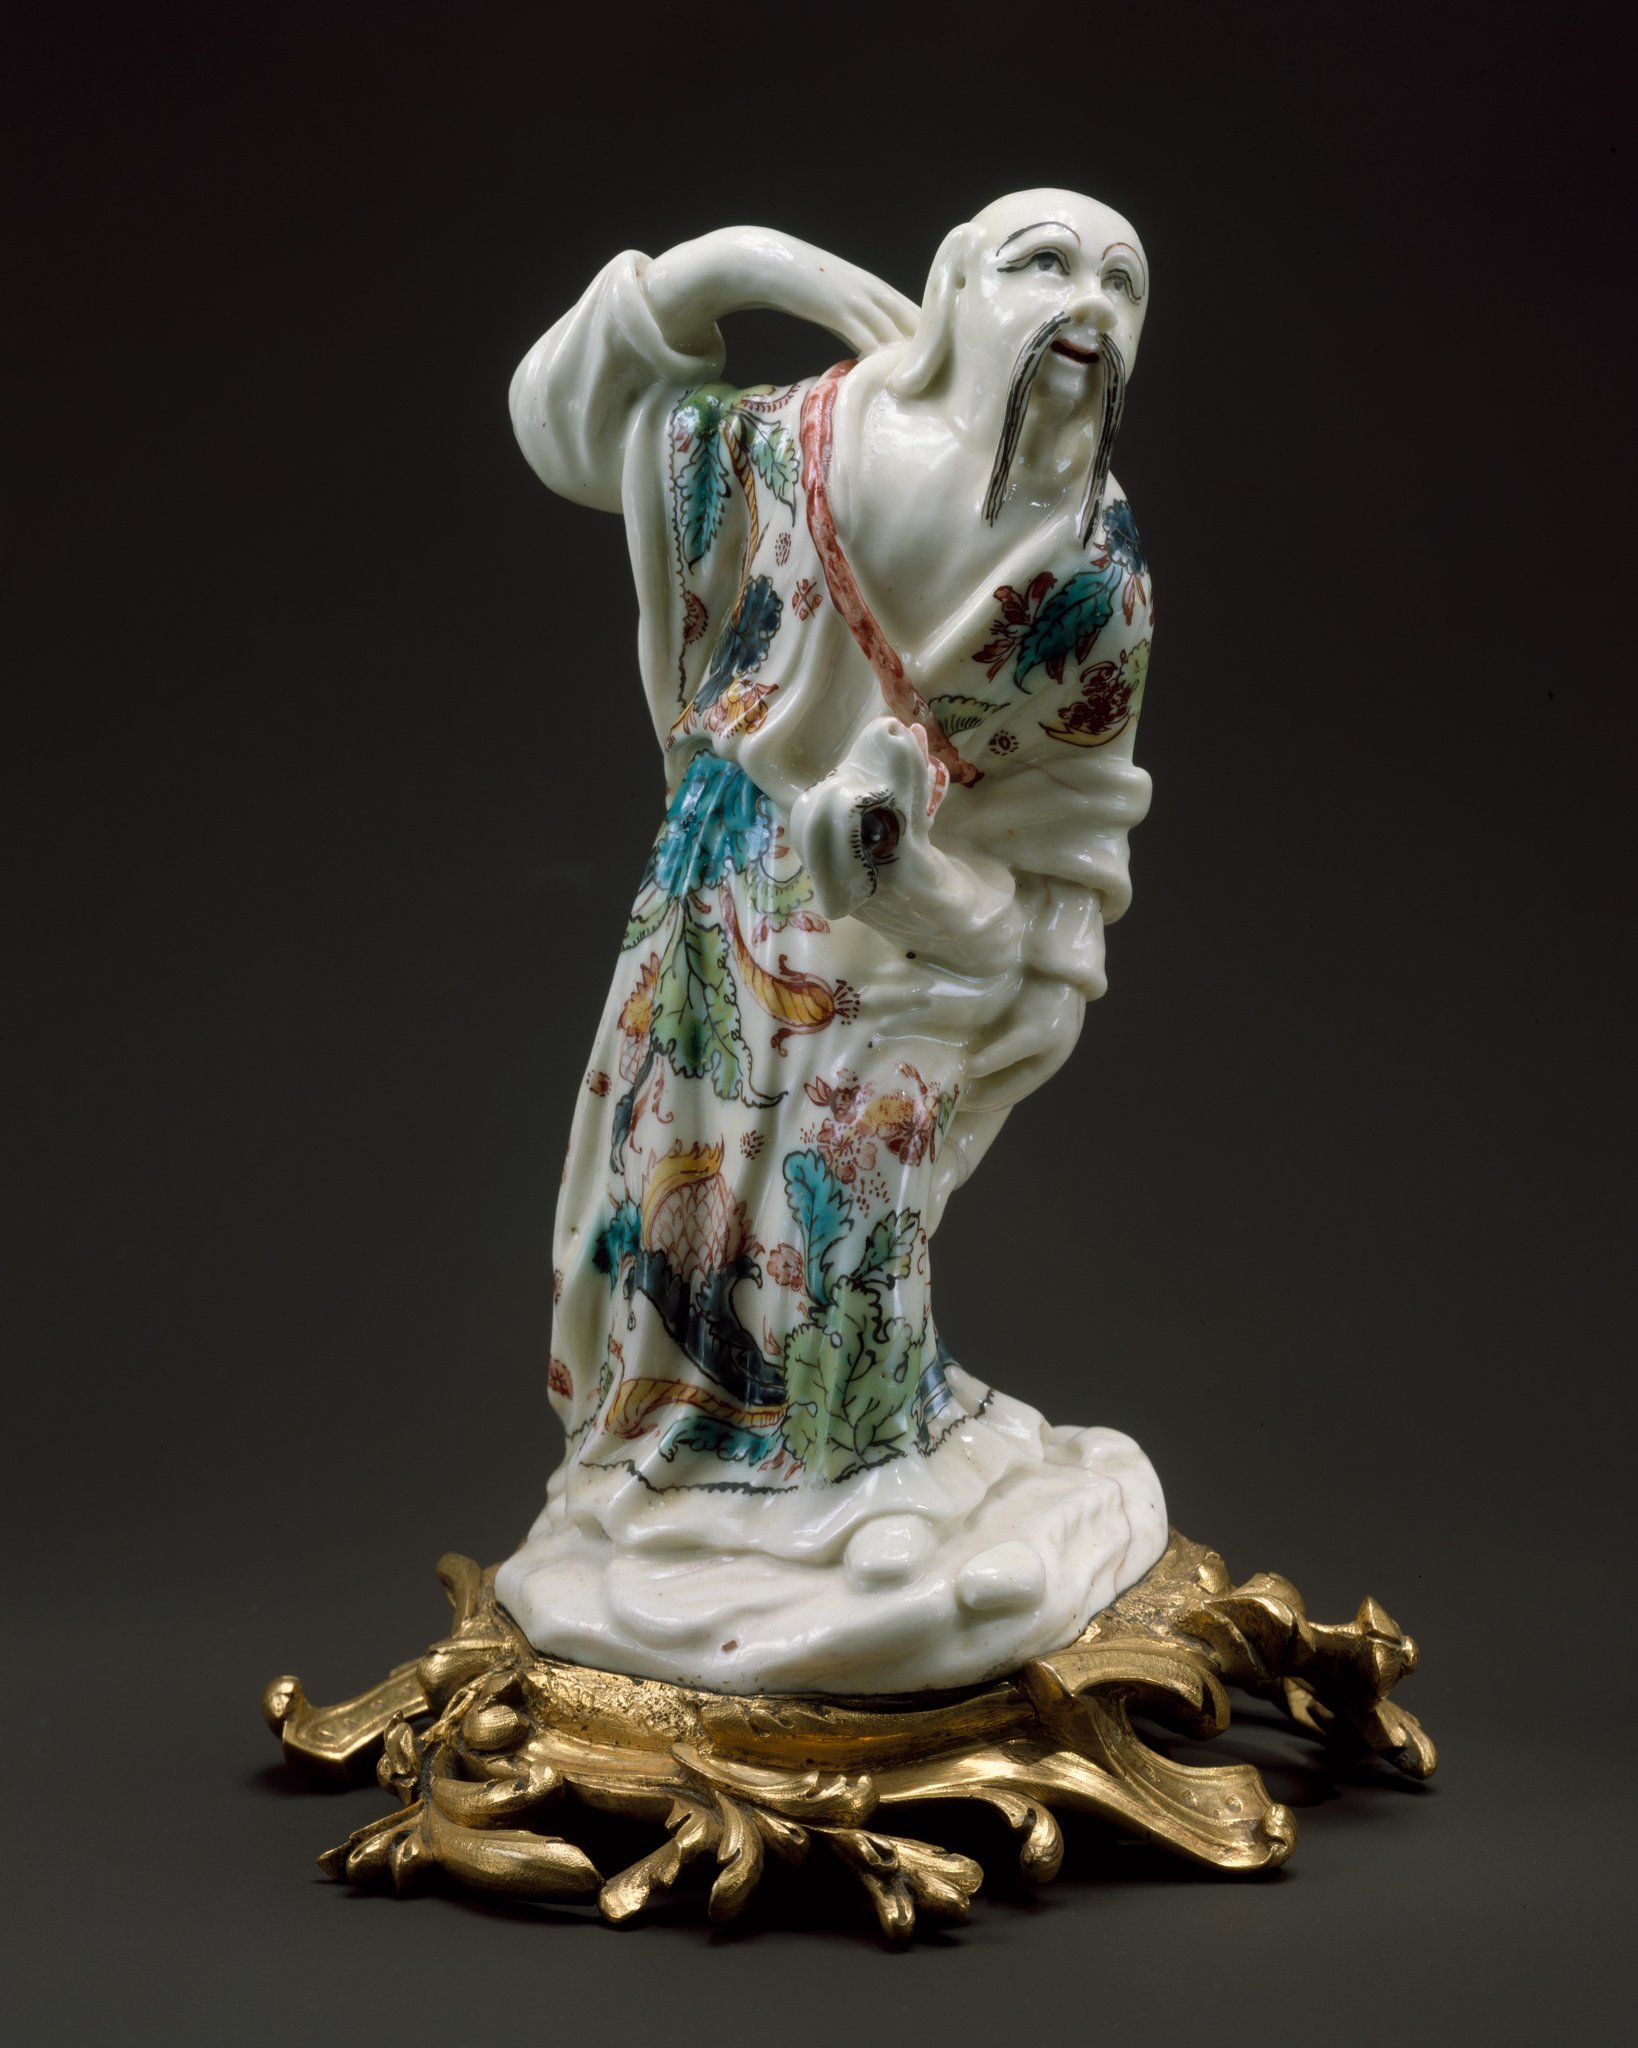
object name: figure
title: Buddhist Ascetic, or Lohan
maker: villeroy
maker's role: factory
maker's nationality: french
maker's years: 1734-1748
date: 1740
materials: gilt bronze, soft paste porcelain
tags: men,buddhism